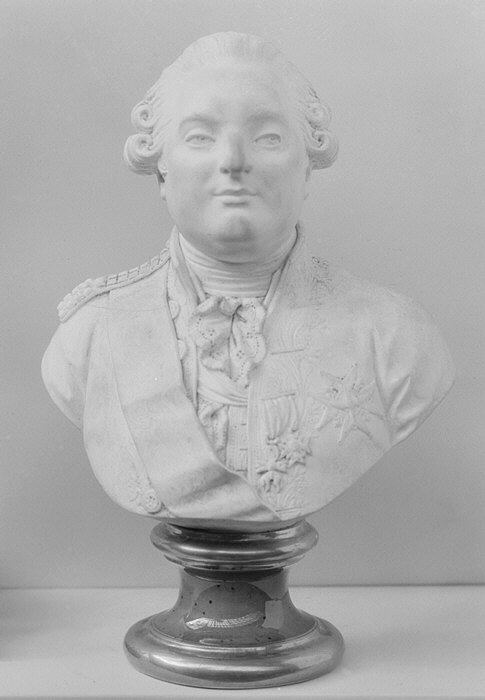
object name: bust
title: Louis XVI (1754–1793, r. 1774–93)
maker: sèvres manufactory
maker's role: manufactory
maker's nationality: french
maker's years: 1740-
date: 1820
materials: biscuit, hard paste porcelain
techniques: glazing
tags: louis xiv,portraits